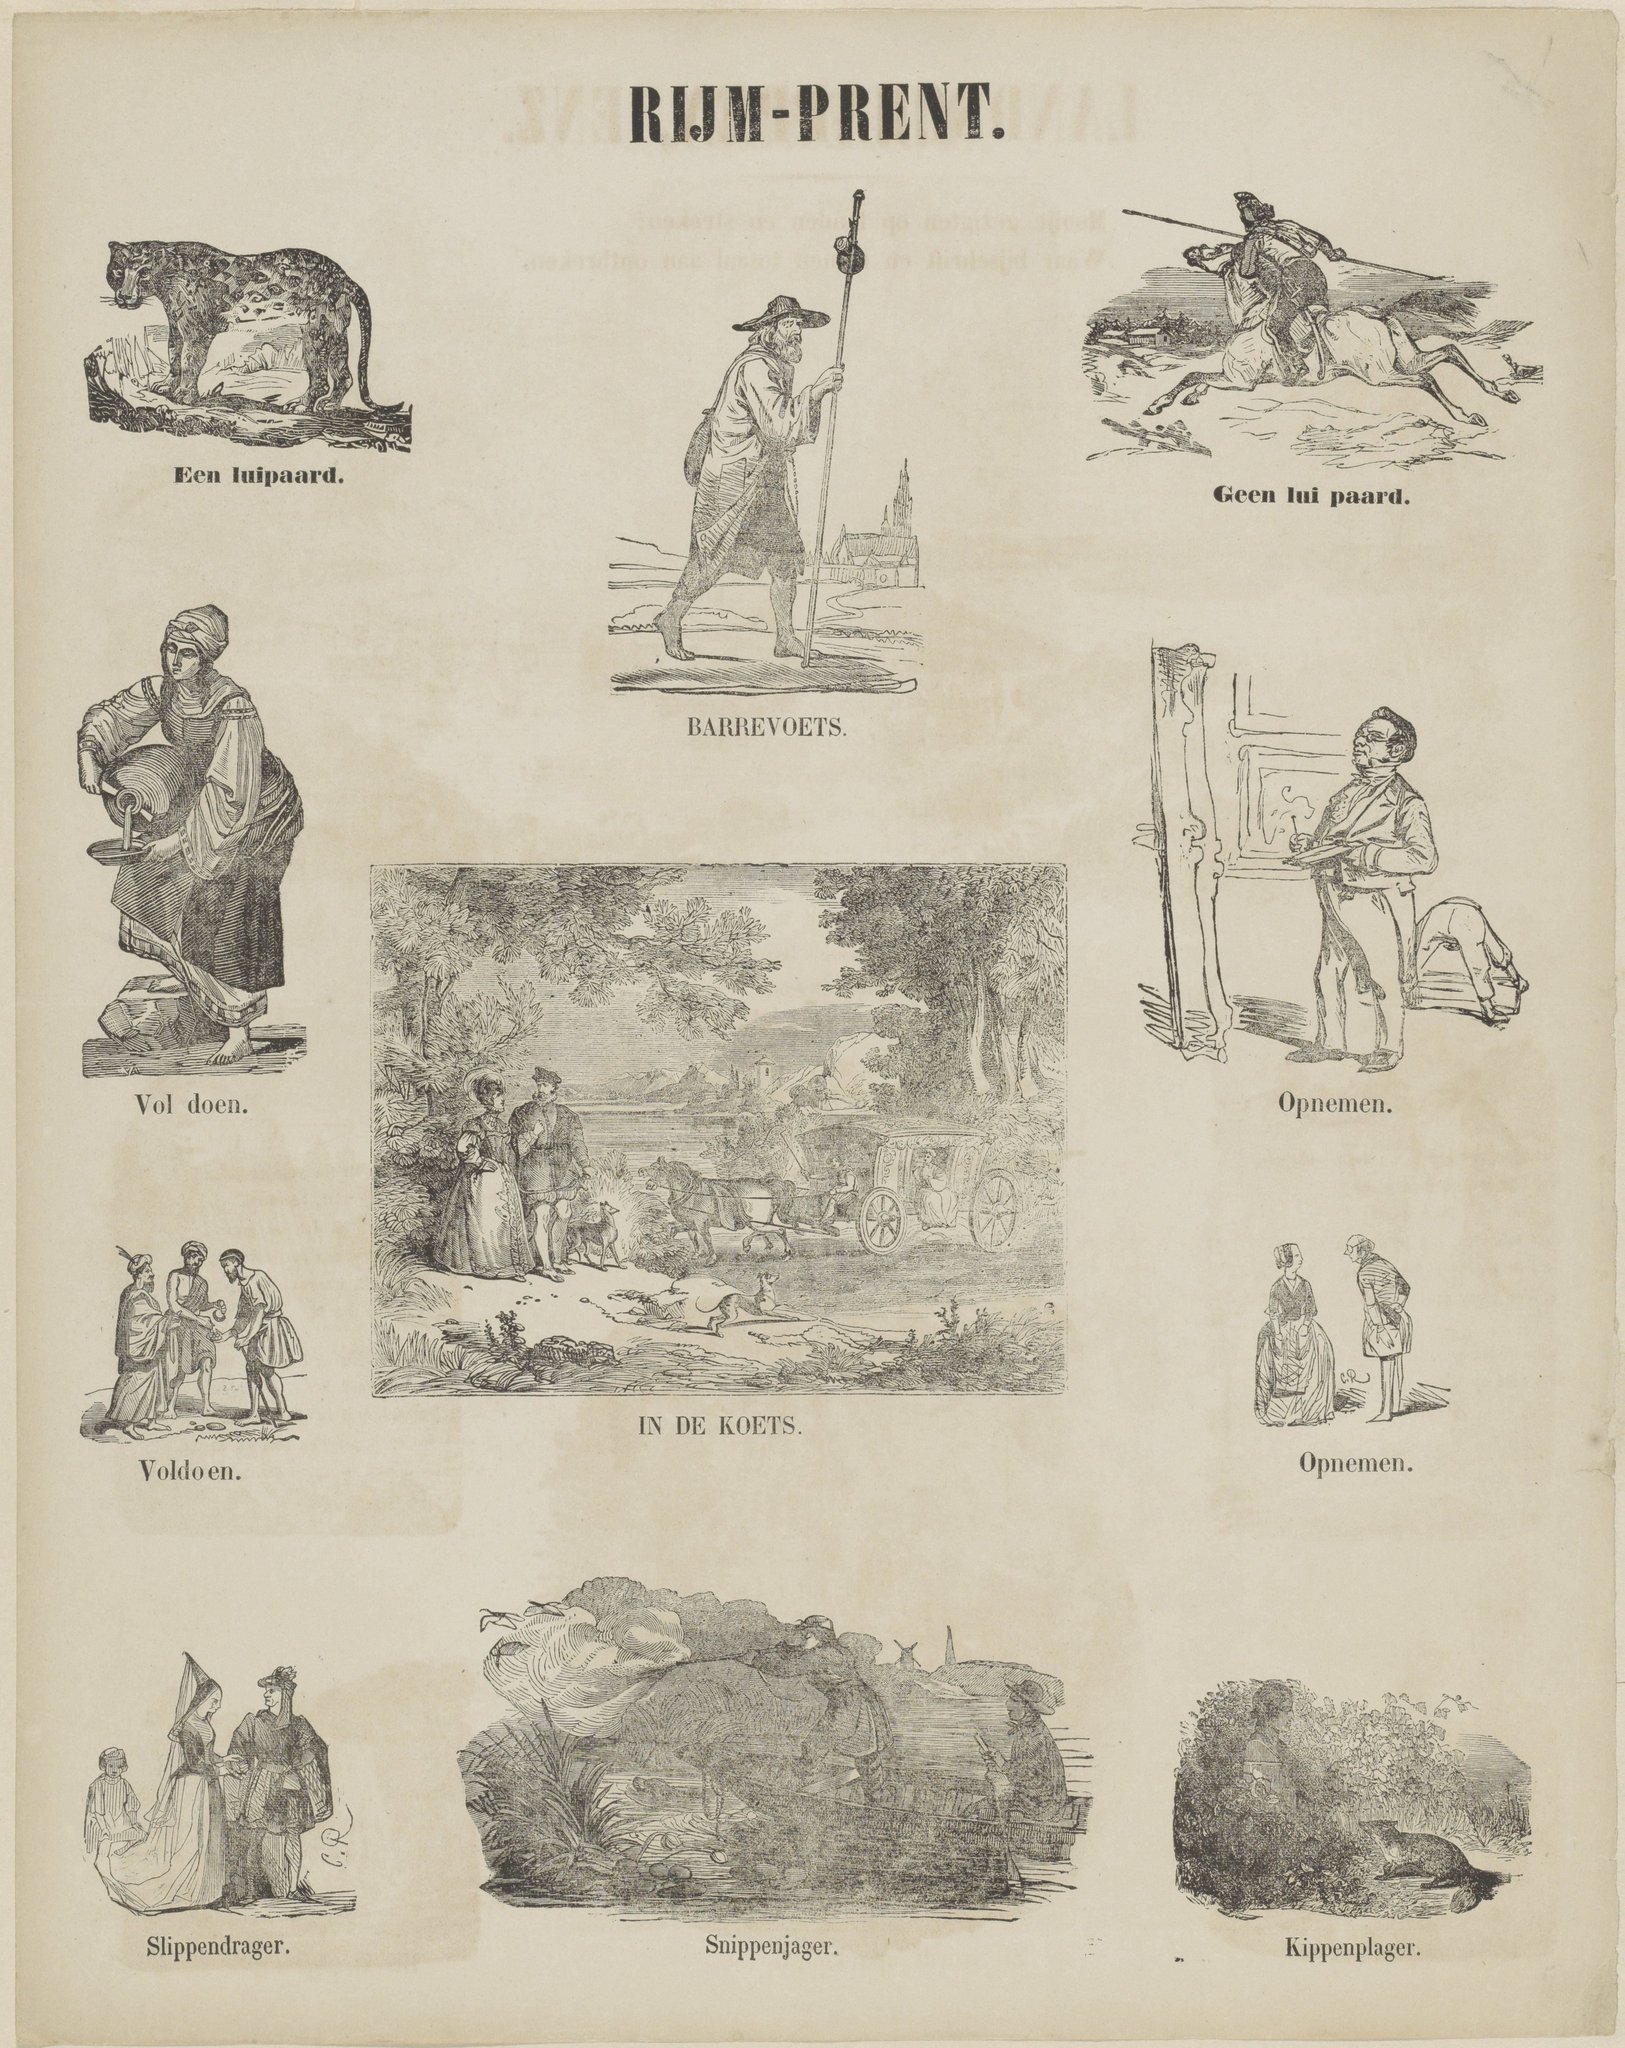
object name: popular print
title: Rijm-prent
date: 1861-1929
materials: paper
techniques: letterpress printing, engraving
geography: europe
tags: beasts of prey, predatory animals: leopard, animals, human types, letters, alphabet, script, four-wheeled, animal-drawn vehicle, e.g.: cab, carriage, coach, characters (human types)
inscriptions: collector's mark: Lugt 2760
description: Blad met 11 voorstellingen van verschillende aard waarvan de woorden rijmen, zoals barrevoets, in de koets, slippendrager en snippenjager. Onder elke voorstelling een onderschrift in boekdruk.